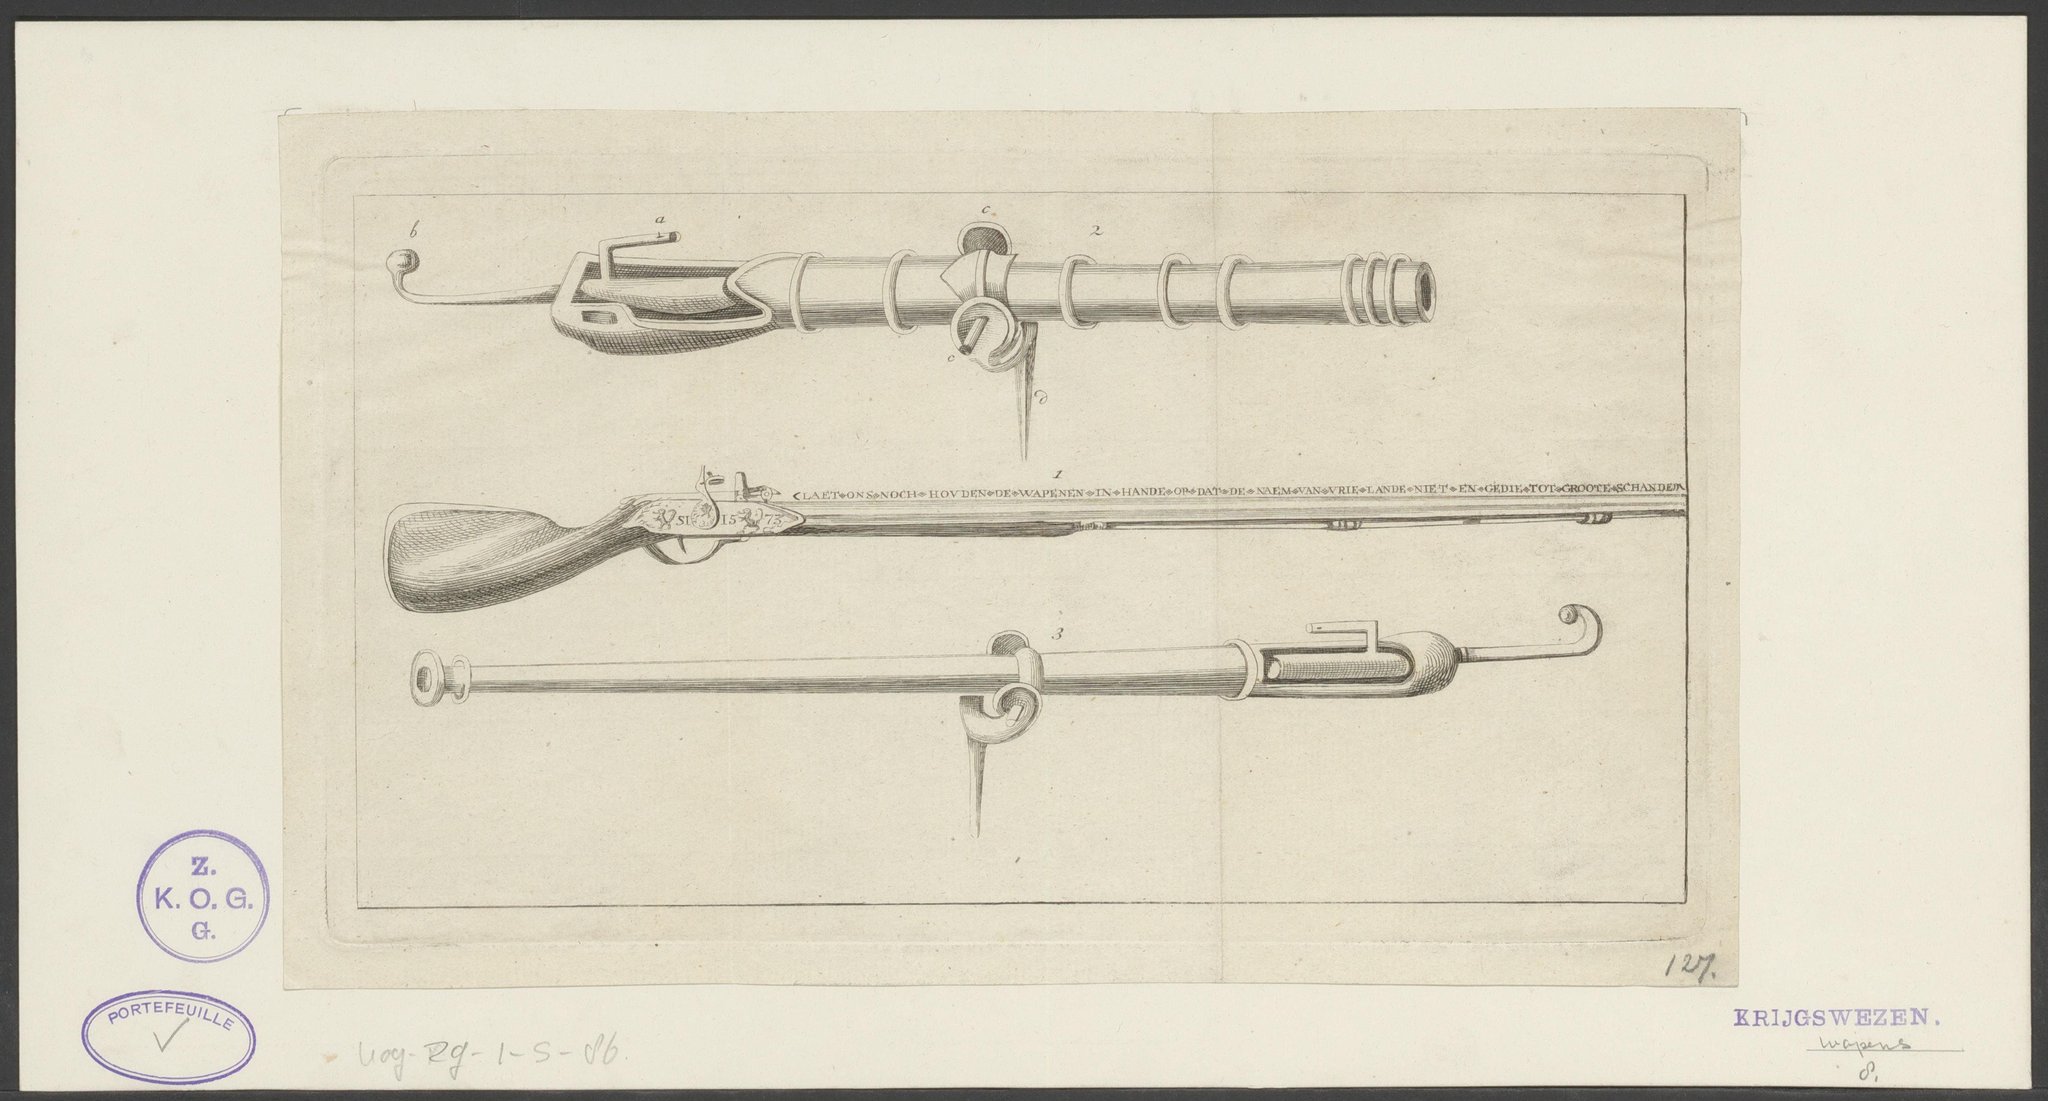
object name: print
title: Snaphaan van Jan van der Does en twee buitgemaakte stukken Spaanse geschut, 1574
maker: johannes le francq van berkhey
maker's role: draughtsman, print maker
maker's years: 1729-1812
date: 1772-1774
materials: paper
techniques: etching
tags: firearms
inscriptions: stamp, collector's mark: Lugt 1641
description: Snaphaan van Jan van der Does, heer van Noordwijk en Kattendijke. Het geweer van Van der Does gemerkt 1573 en met de transcriptie van de inscriptie op de loop. Daarboven en onder twee buitgemaakte stukken Spaanse geschut, tijdens het beleg van Leiden in 1574. Onderwerpsrubrieken binnen de Atlas Zeden en Gewoonten: Krijgswezen, Wapens.